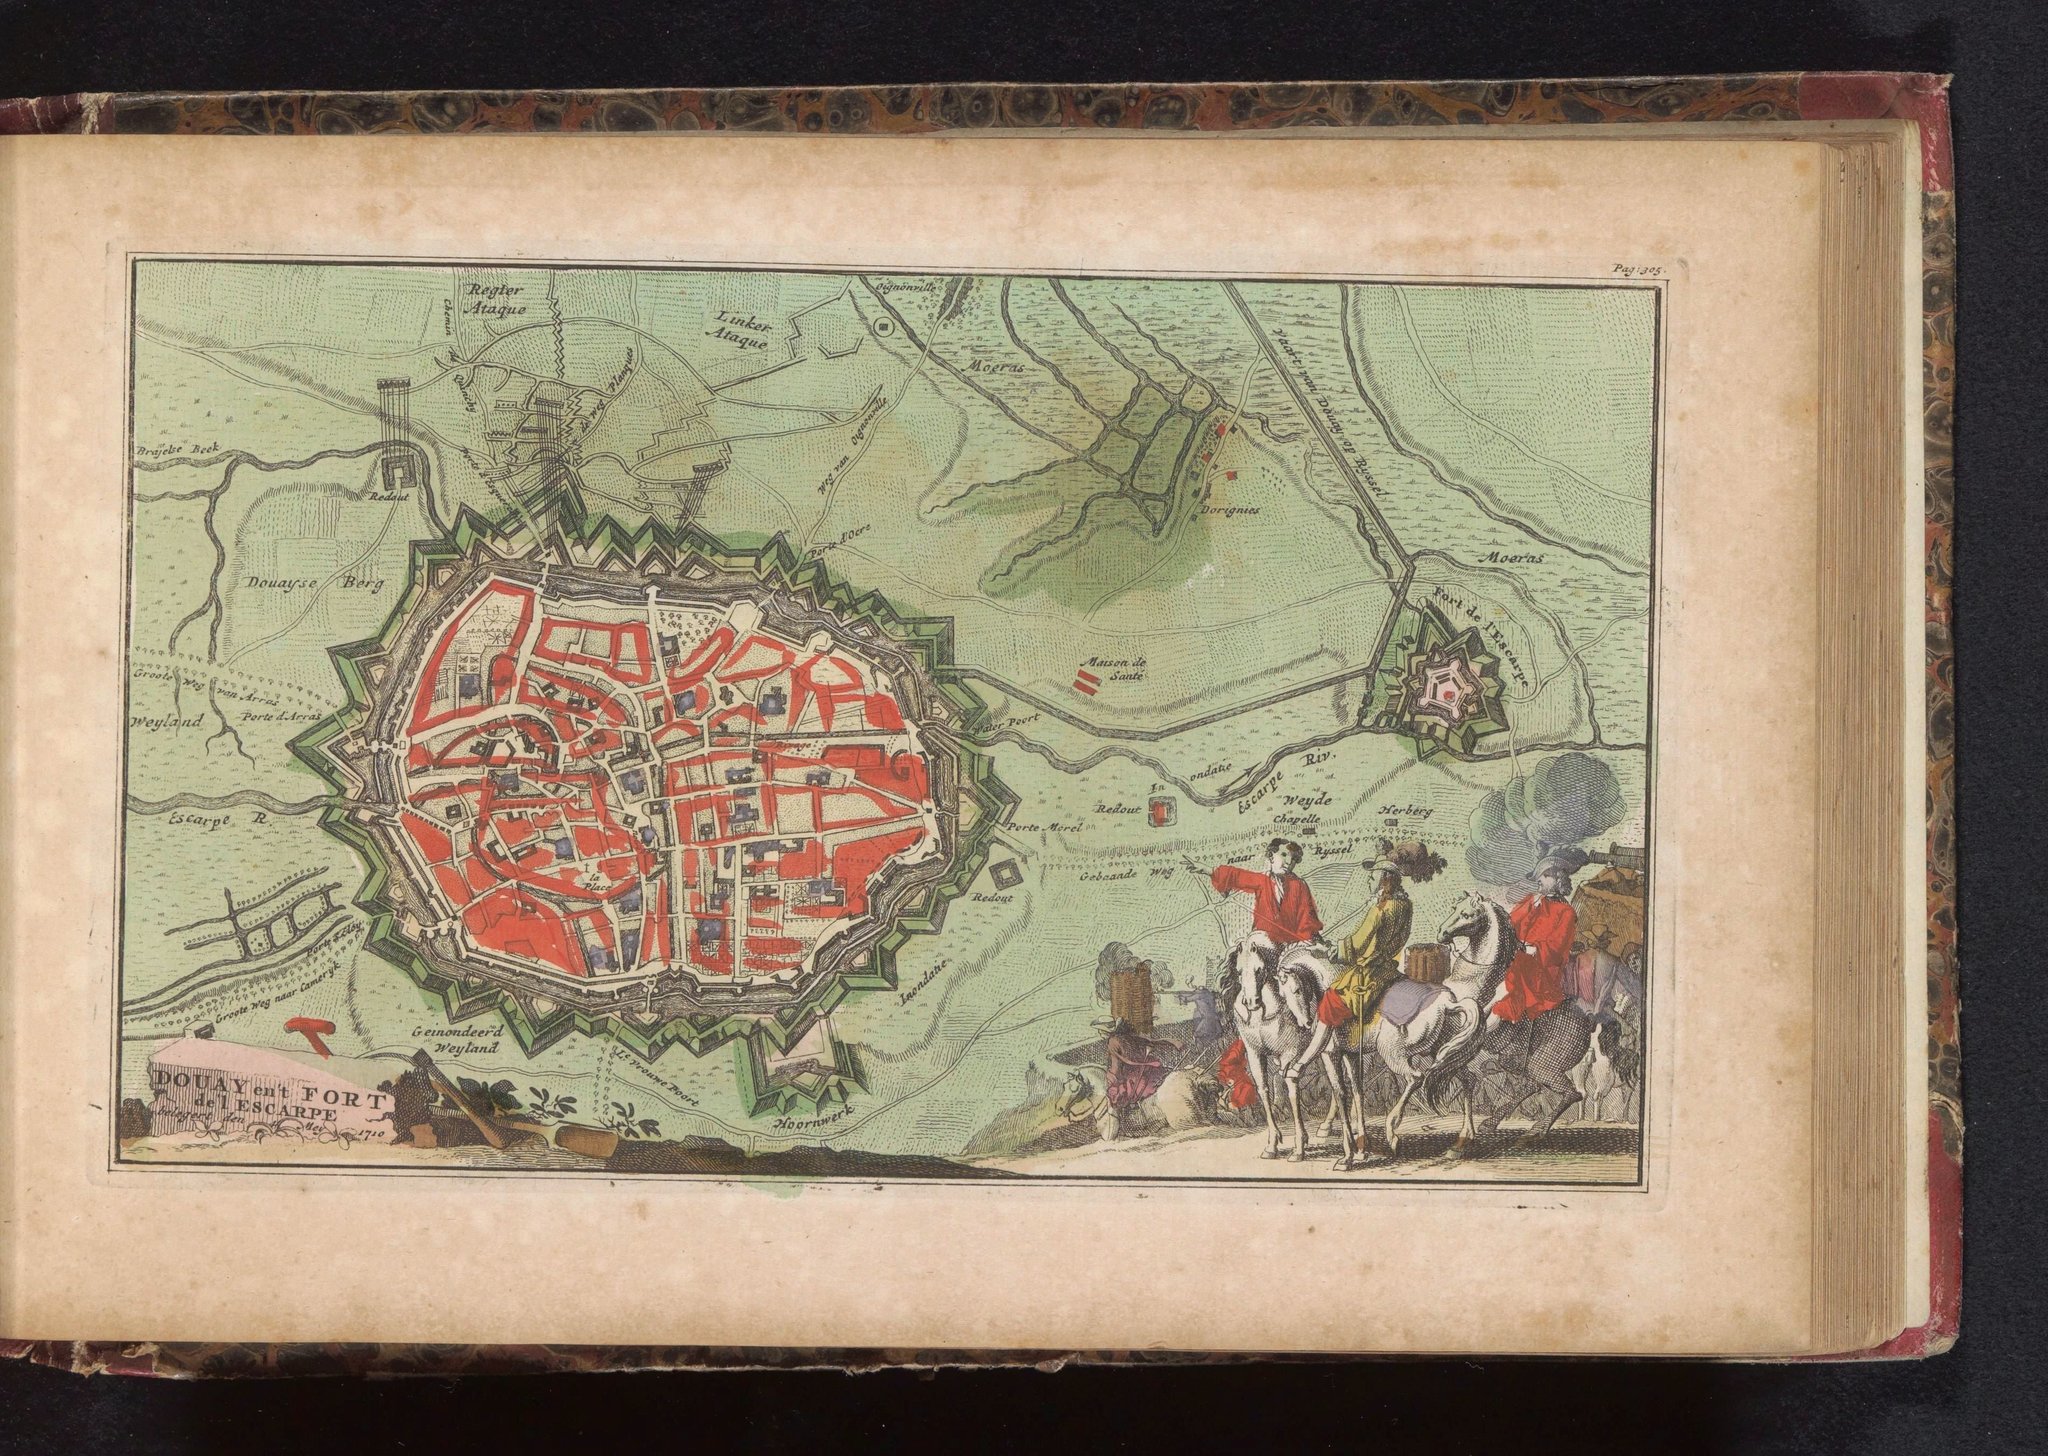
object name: map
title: Beleg van Douai, 1710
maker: Anonymous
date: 1735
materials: paper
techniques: engraving, etching, hand coloring, lacquer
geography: northern netherlands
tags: fortified city, maps of cities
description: Plattegrond van de versterkingen om de stad Douai, belegerd door de Geallieerden in mei 1710. Rechtsonder een groep ruiters. Onderdeel van een atlas met 223 kaarten van landen en steden en oorlogstaferelen in Europa in de periode ca. 1690-1735.